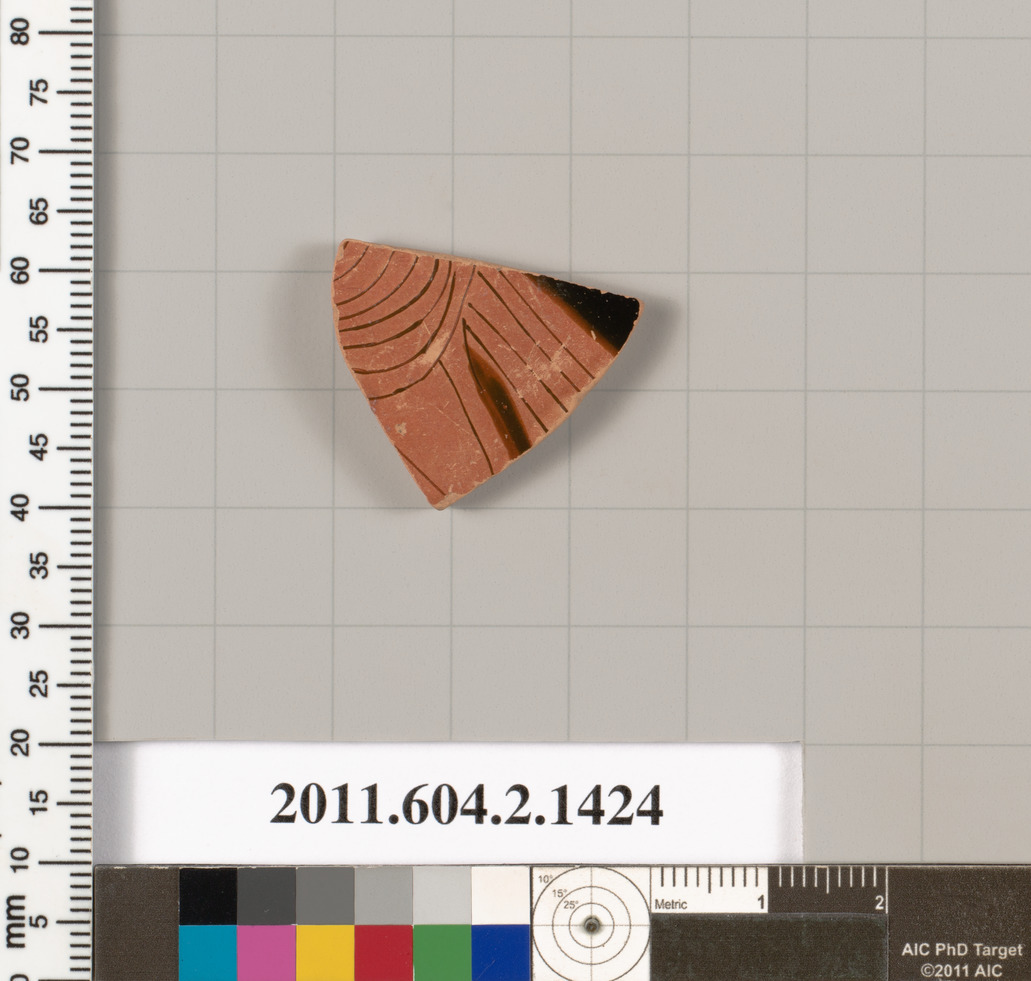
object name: skyphos fragment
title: Terracotta fragment of a skyphos (deep drinking cup)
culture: greek, attic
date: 450-426 BCE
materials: terracotta